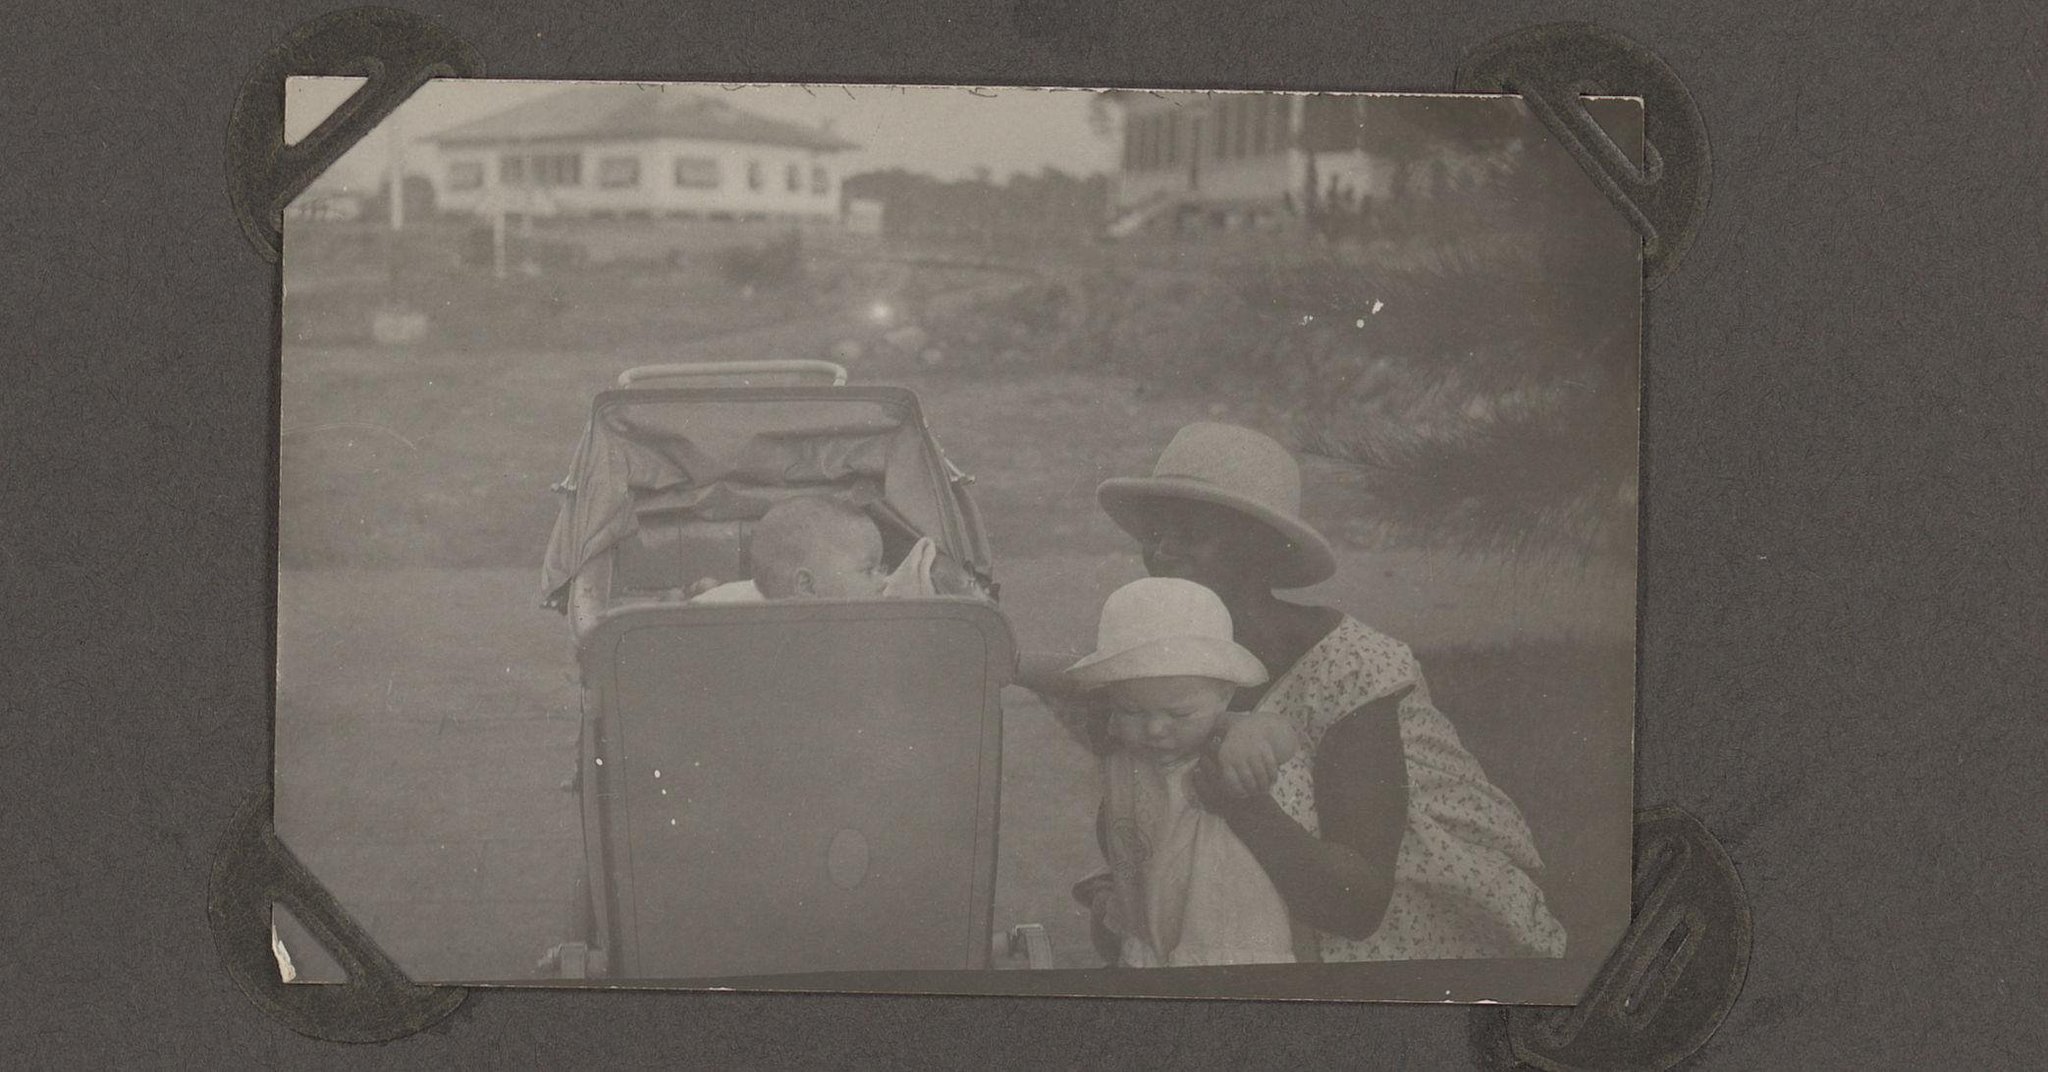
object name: photograph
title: Familiefoto van de kinderen Jetten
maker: Anonymous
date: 1925-1927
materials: photographic support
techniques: photography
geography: suriname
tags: jetten, familie, moengo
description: Familiefoto van de kinderen Jetten met hun Surinaamse kinderjuffrouw. Foto op een bladzijde van een los albumblad. Onderdeel van het ensemble met foto's van de familie van ingenieur Jetten in de mijnbouwstad Moengo in Suriname.